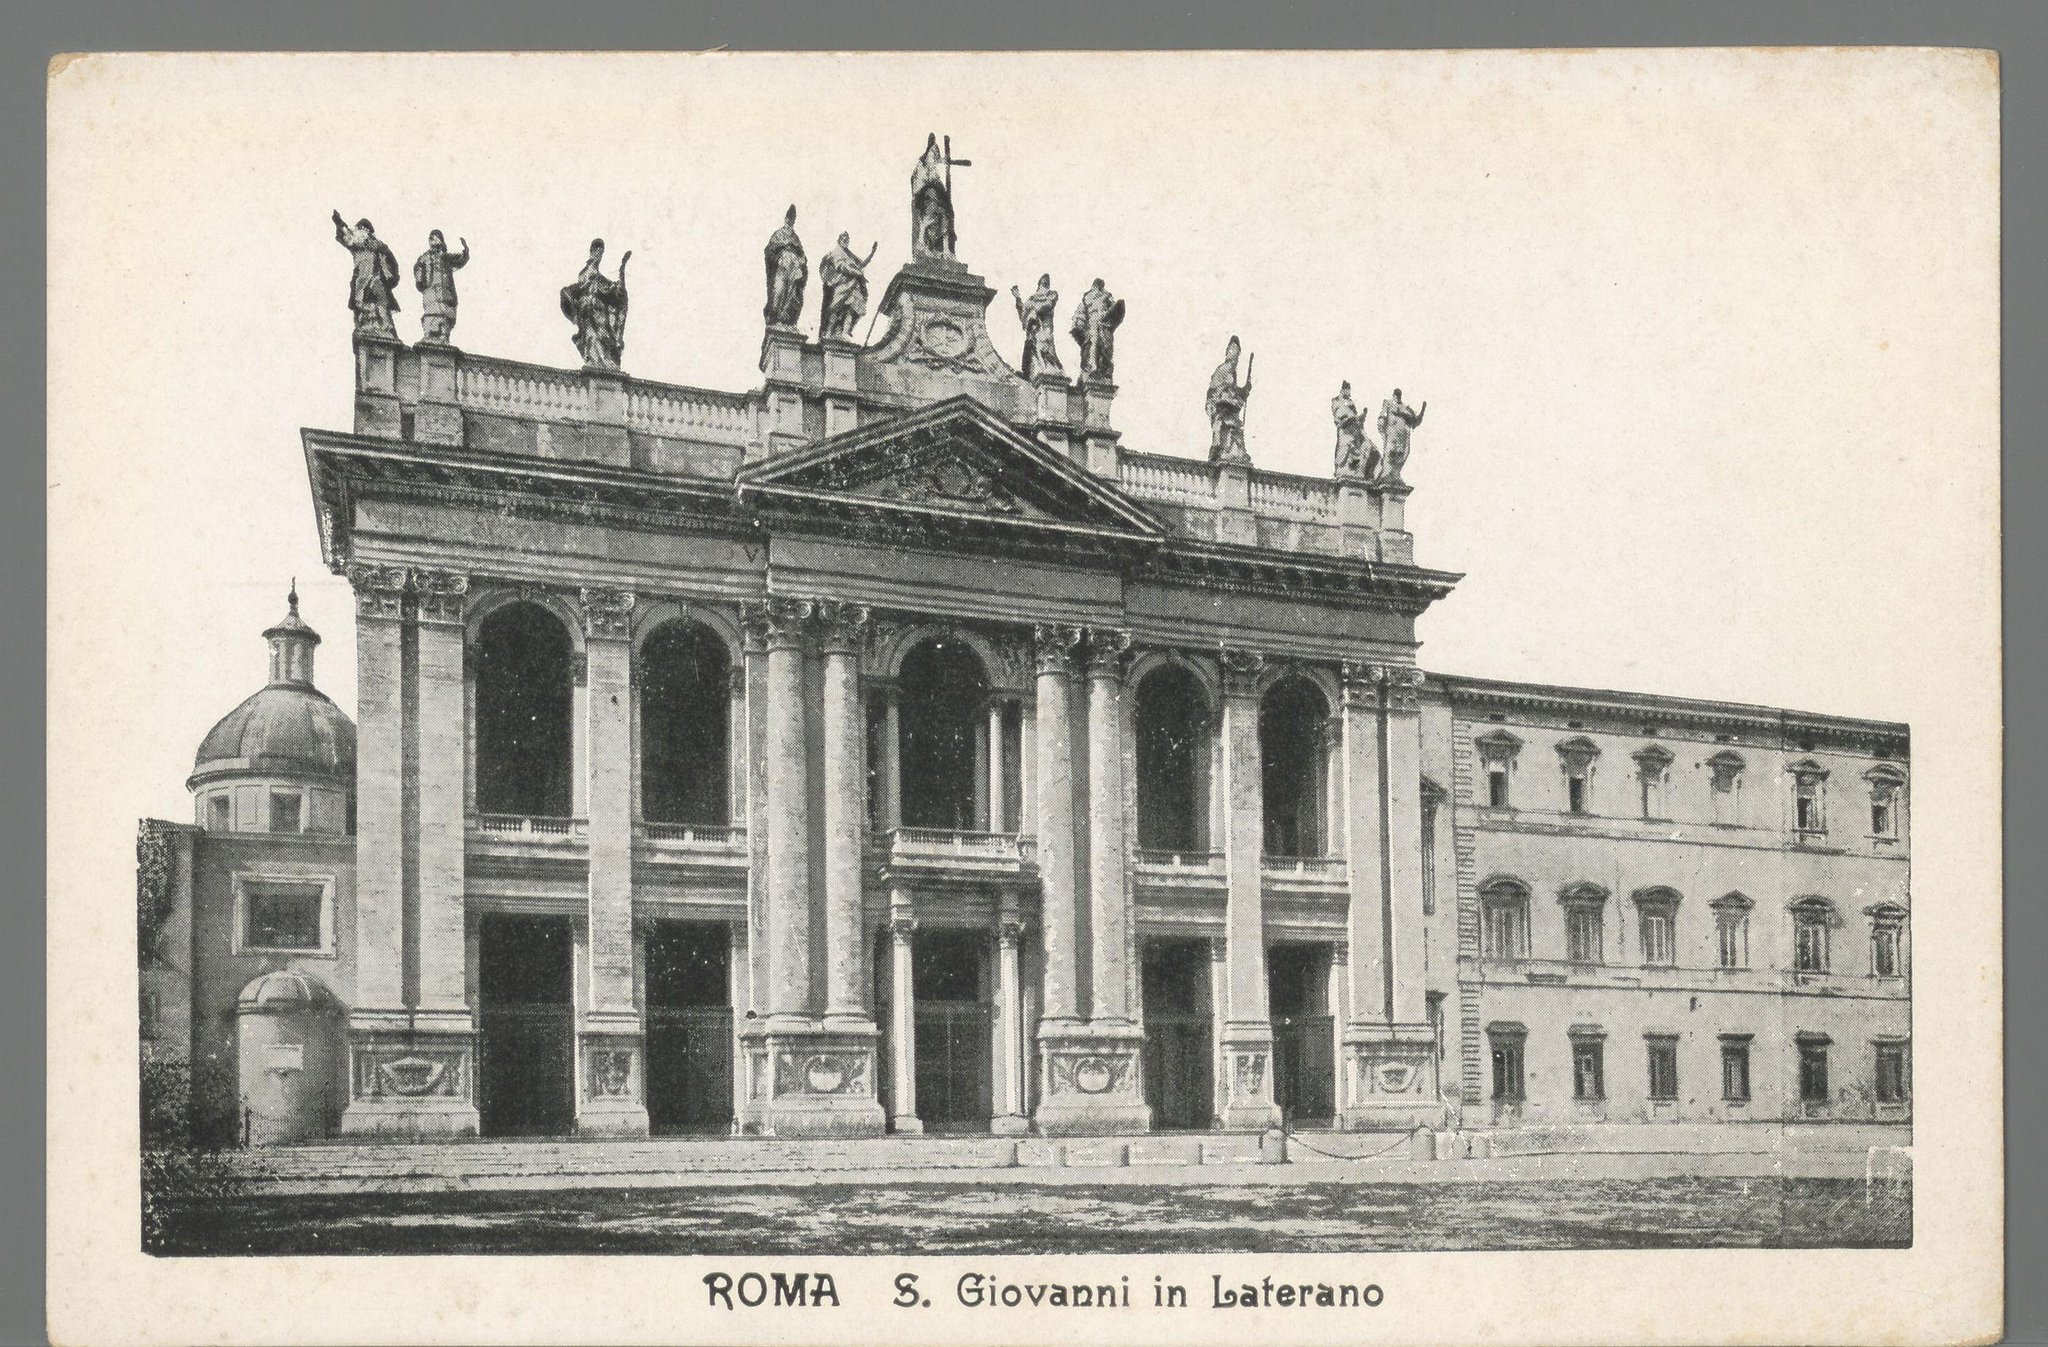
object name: photomechanical print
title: Roma. S. Giovanni in Laterano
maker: Anonymous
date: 1906-1930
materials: cardboard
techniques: autotype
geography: rome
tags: church (exterior)